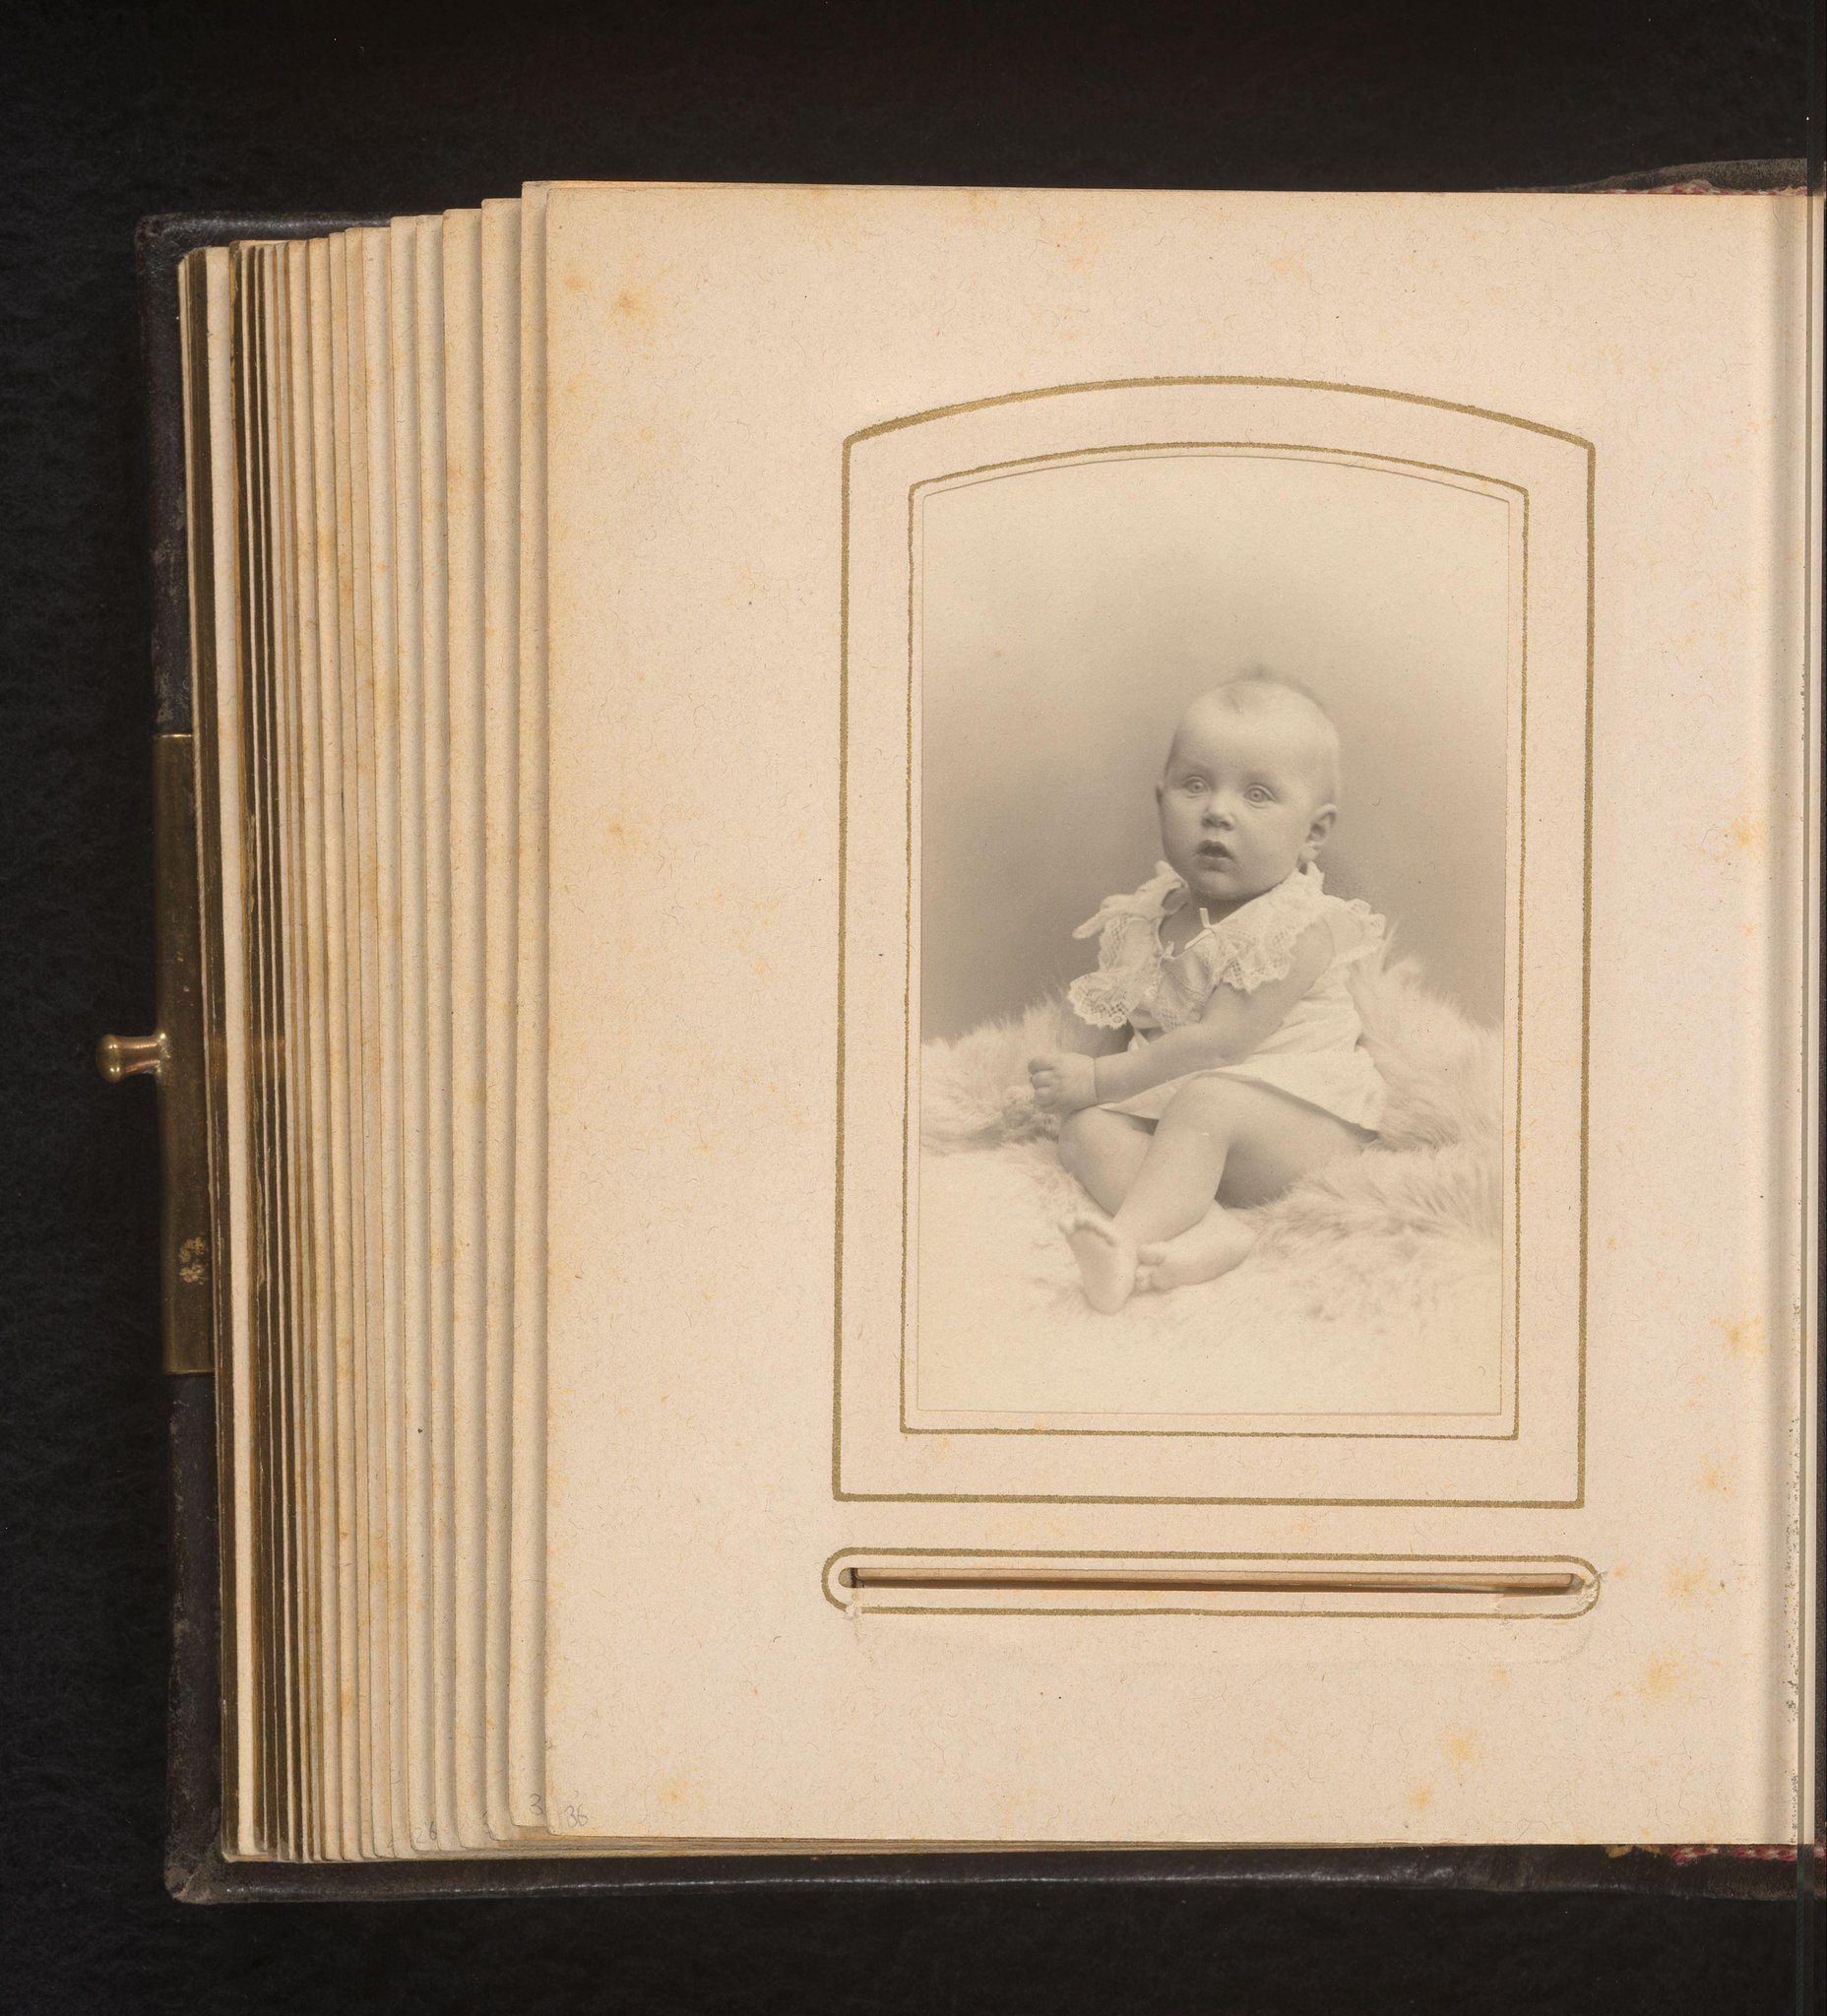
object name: album leaf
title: Portret van een baby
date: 1880-1910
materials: cardboard, photographic support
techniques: collodion silver print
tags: historical persons, infant, baby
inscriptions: inscription: ‘Hof-Photograhen/ L. Stüting u. Sohn/ vorm. C. Freund/ Bonn a/ Rhein/ Coblenzerstr. 14’